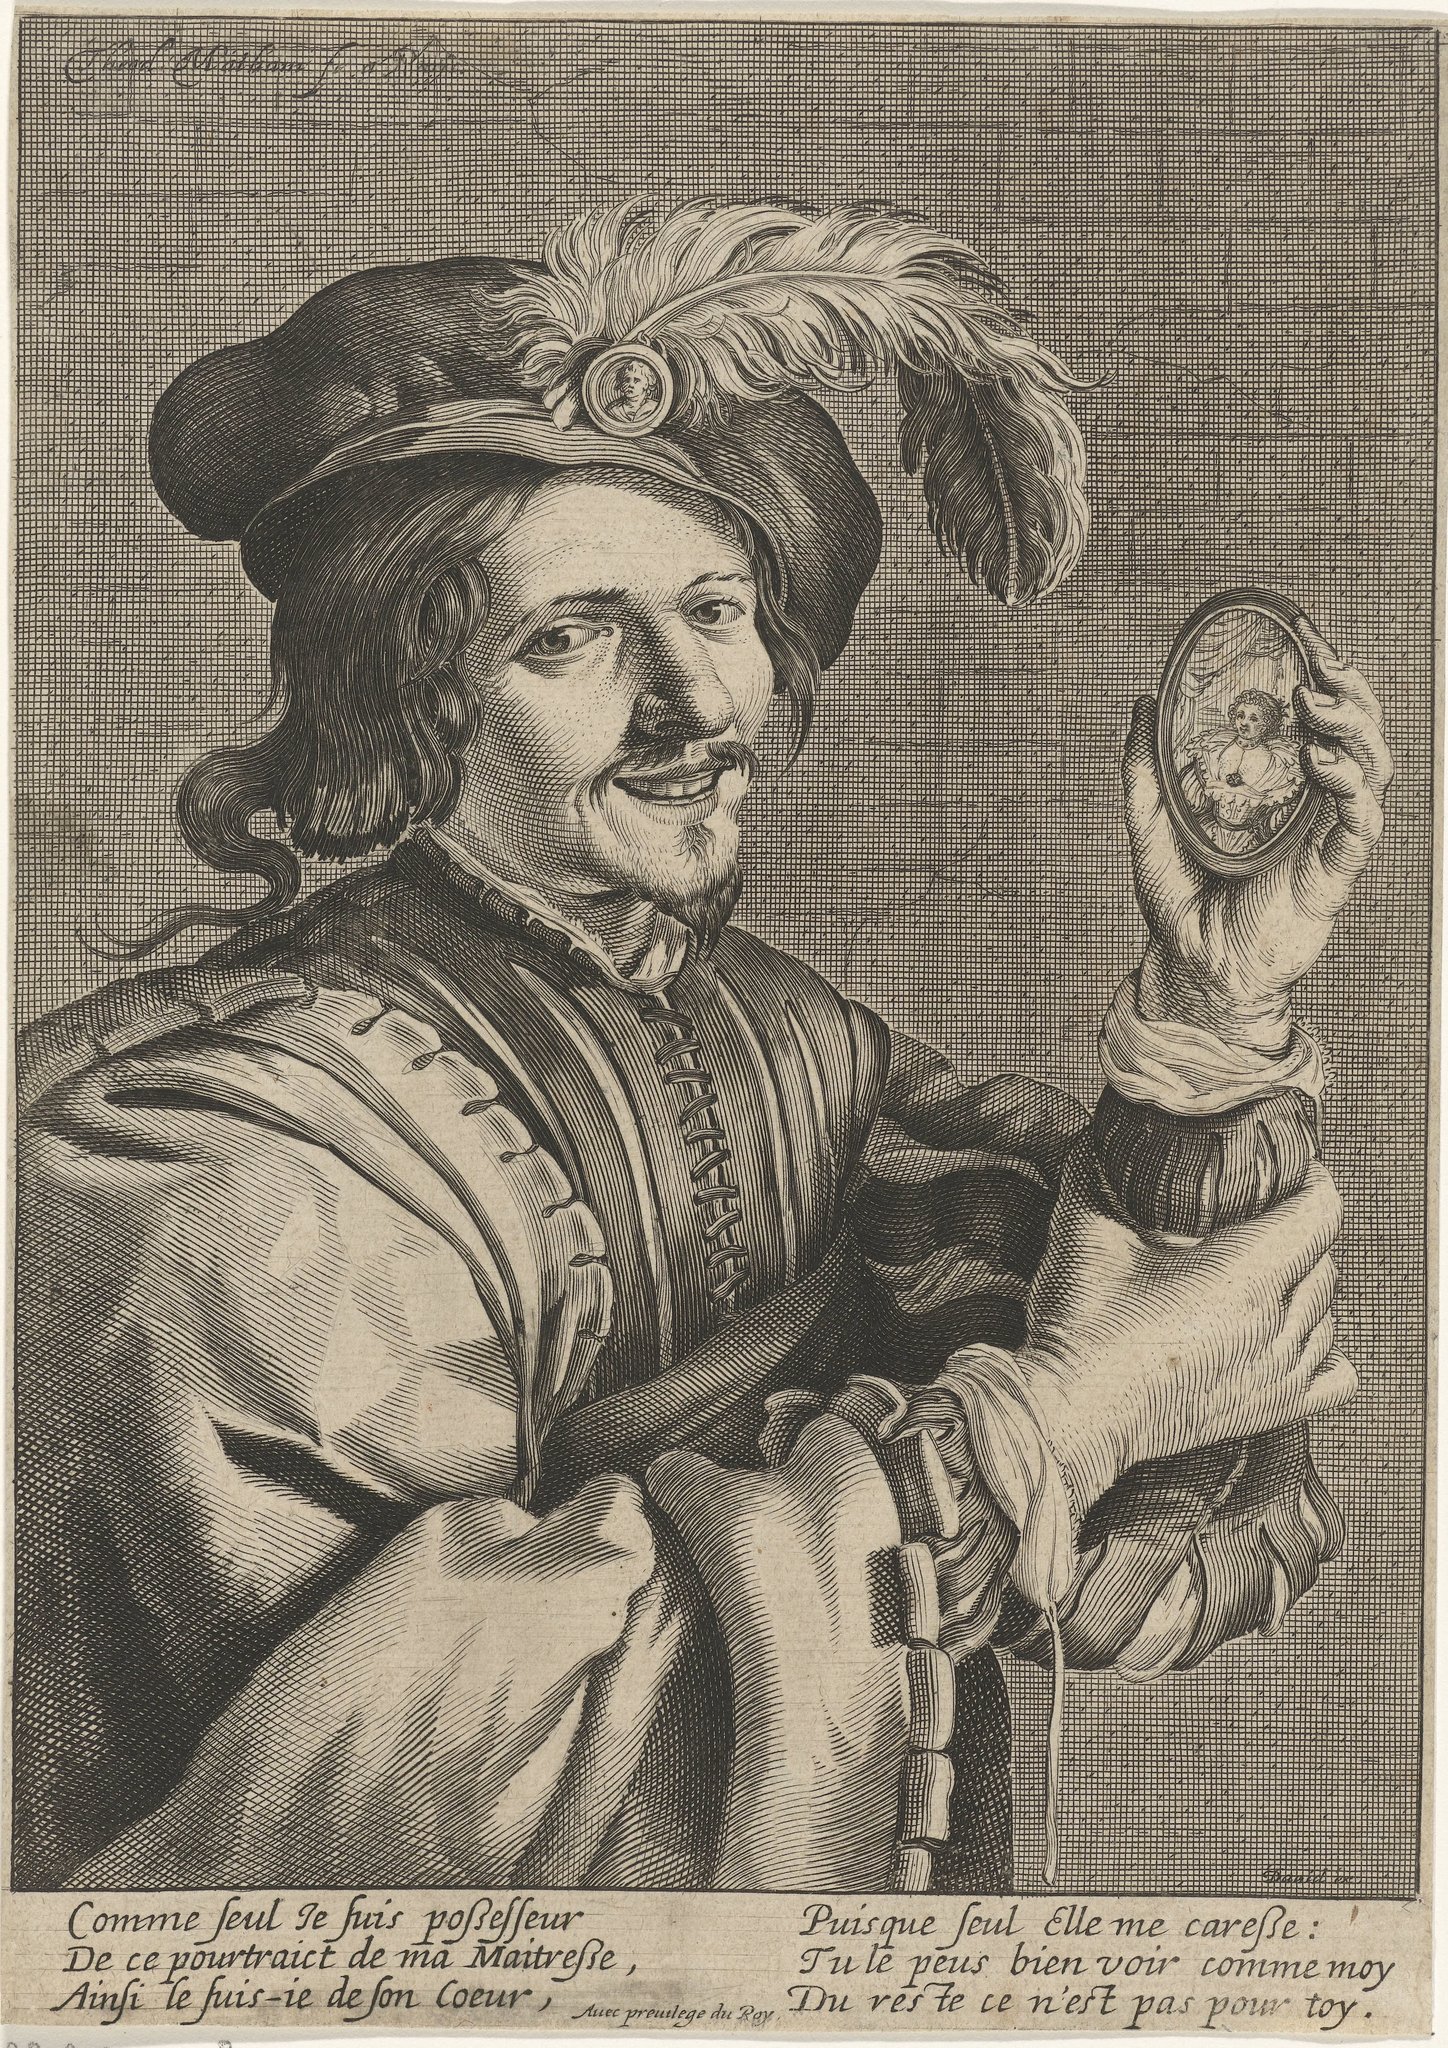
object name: print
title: Man met miniatuurportret in de hand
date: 1615-1676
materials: paper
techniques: engraving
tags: painting (including book-illumination, miniature-painting)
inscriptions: signature: ‘Theod. Matham fe et sculp’, address: ‘David ex.’, poem: ‘Comme seul je puis possesseur / De ce pourtraict de ma Maistresse,/ Ainsi je suis de son coeur, // Puisque seul Elle me caresse: / Tu le peus bien voir comme moy / Du reste ce n'est pas pour toy.’, collector's mark: Lugt 2228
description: Jonge man met een muts met een veer op het hoofd. In de linkerhand houdt hij een miniatuur vrouwenportret.